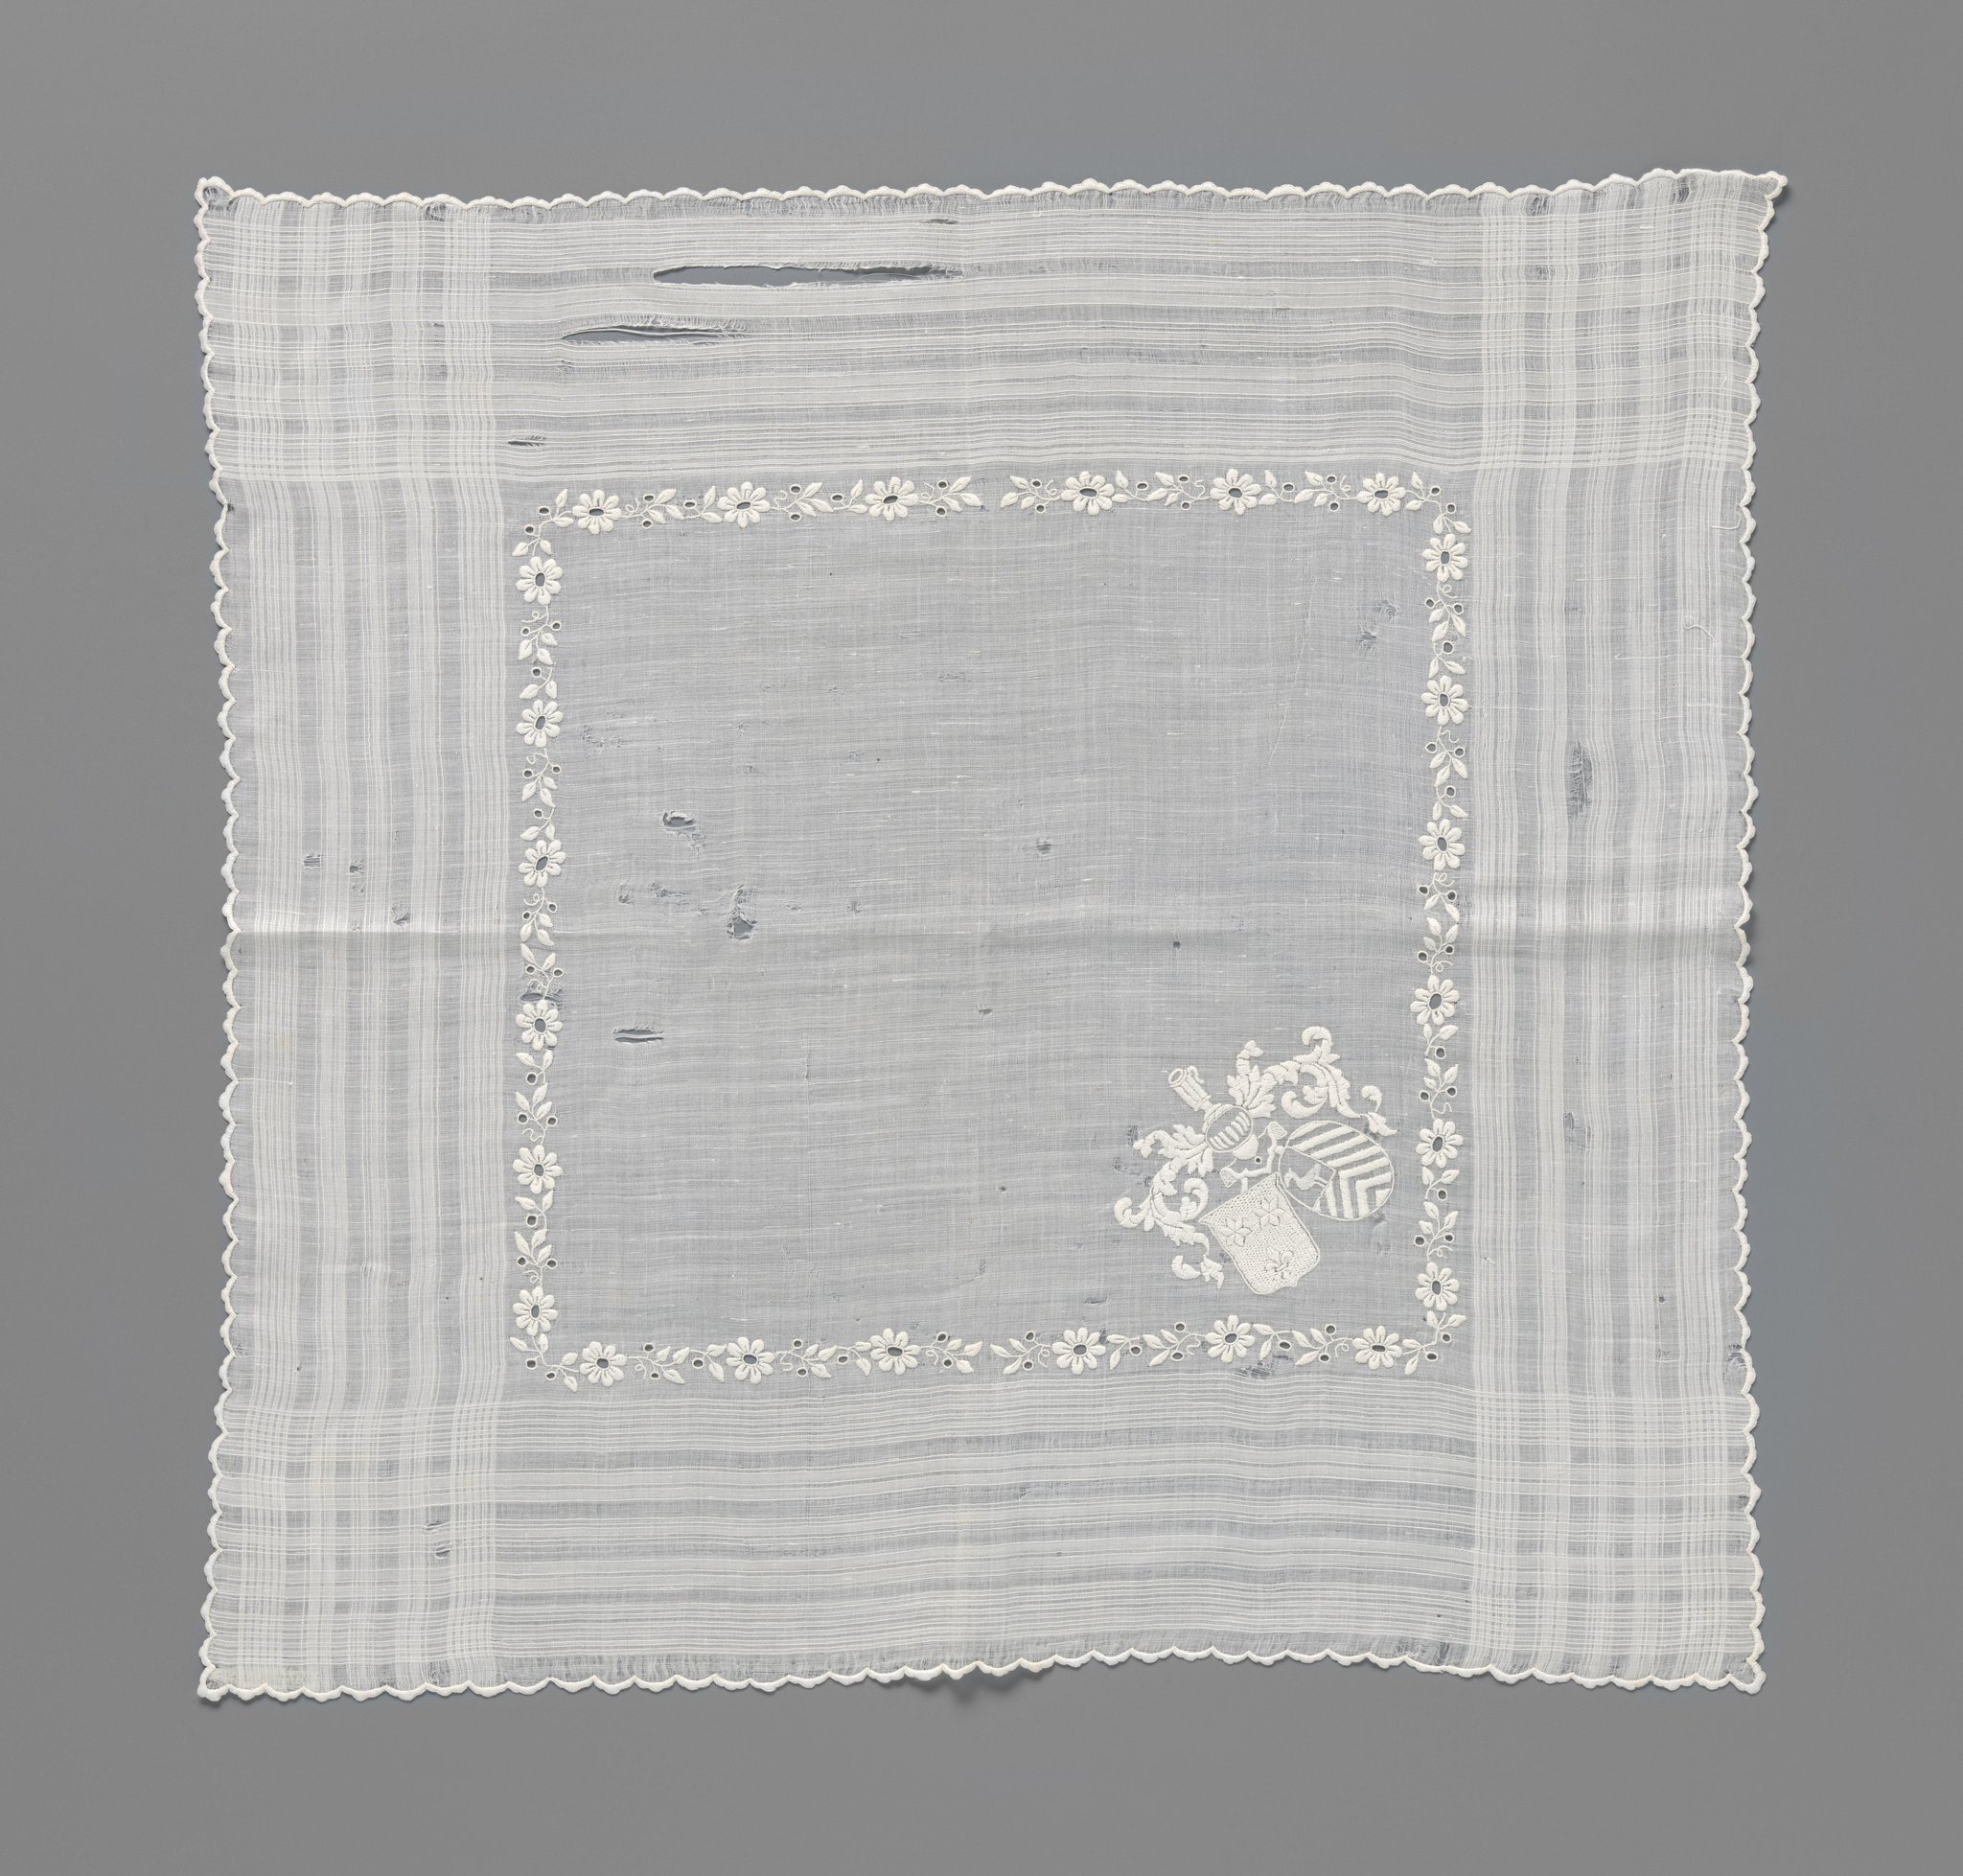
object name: clothing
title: Zakdoek met geborduurde wapens van Bosch Reitz en Teding van Berkhout en een randje rond het middenveld met rozetbloempjes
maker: Anonymous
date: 1859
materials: textile, linen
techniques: embroidered, satin stitch, shadow quilted, weave, embroidery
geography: netherlands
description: Zakdoek van naturelkleurig batist met ingeweven strepen langs de randen en schuin in één hoek geplaatst een motief in borduurwerk: witwerk. Het geborduurde motief betreft de alliantiewapens van Bosch Reitz en Teding van Berkhout. Borduurtechniek: satijnsteek, steelsteek, stiksteek, zandsteek, en flanelsteek. Wapens: de wapens staan schuin tegen elkaar aan geleund en worden gezamelijk gekroond door een helmteken met blaker, die wordt geflankeerd door acanthusbladeren. Op het wapenschild van Bosch Reitz staan twee sterren boven een franse lelie. Op het wapen van Teding van Berkhout staan kepers en een zwaan. rond het middenveld met rozetbloempjes